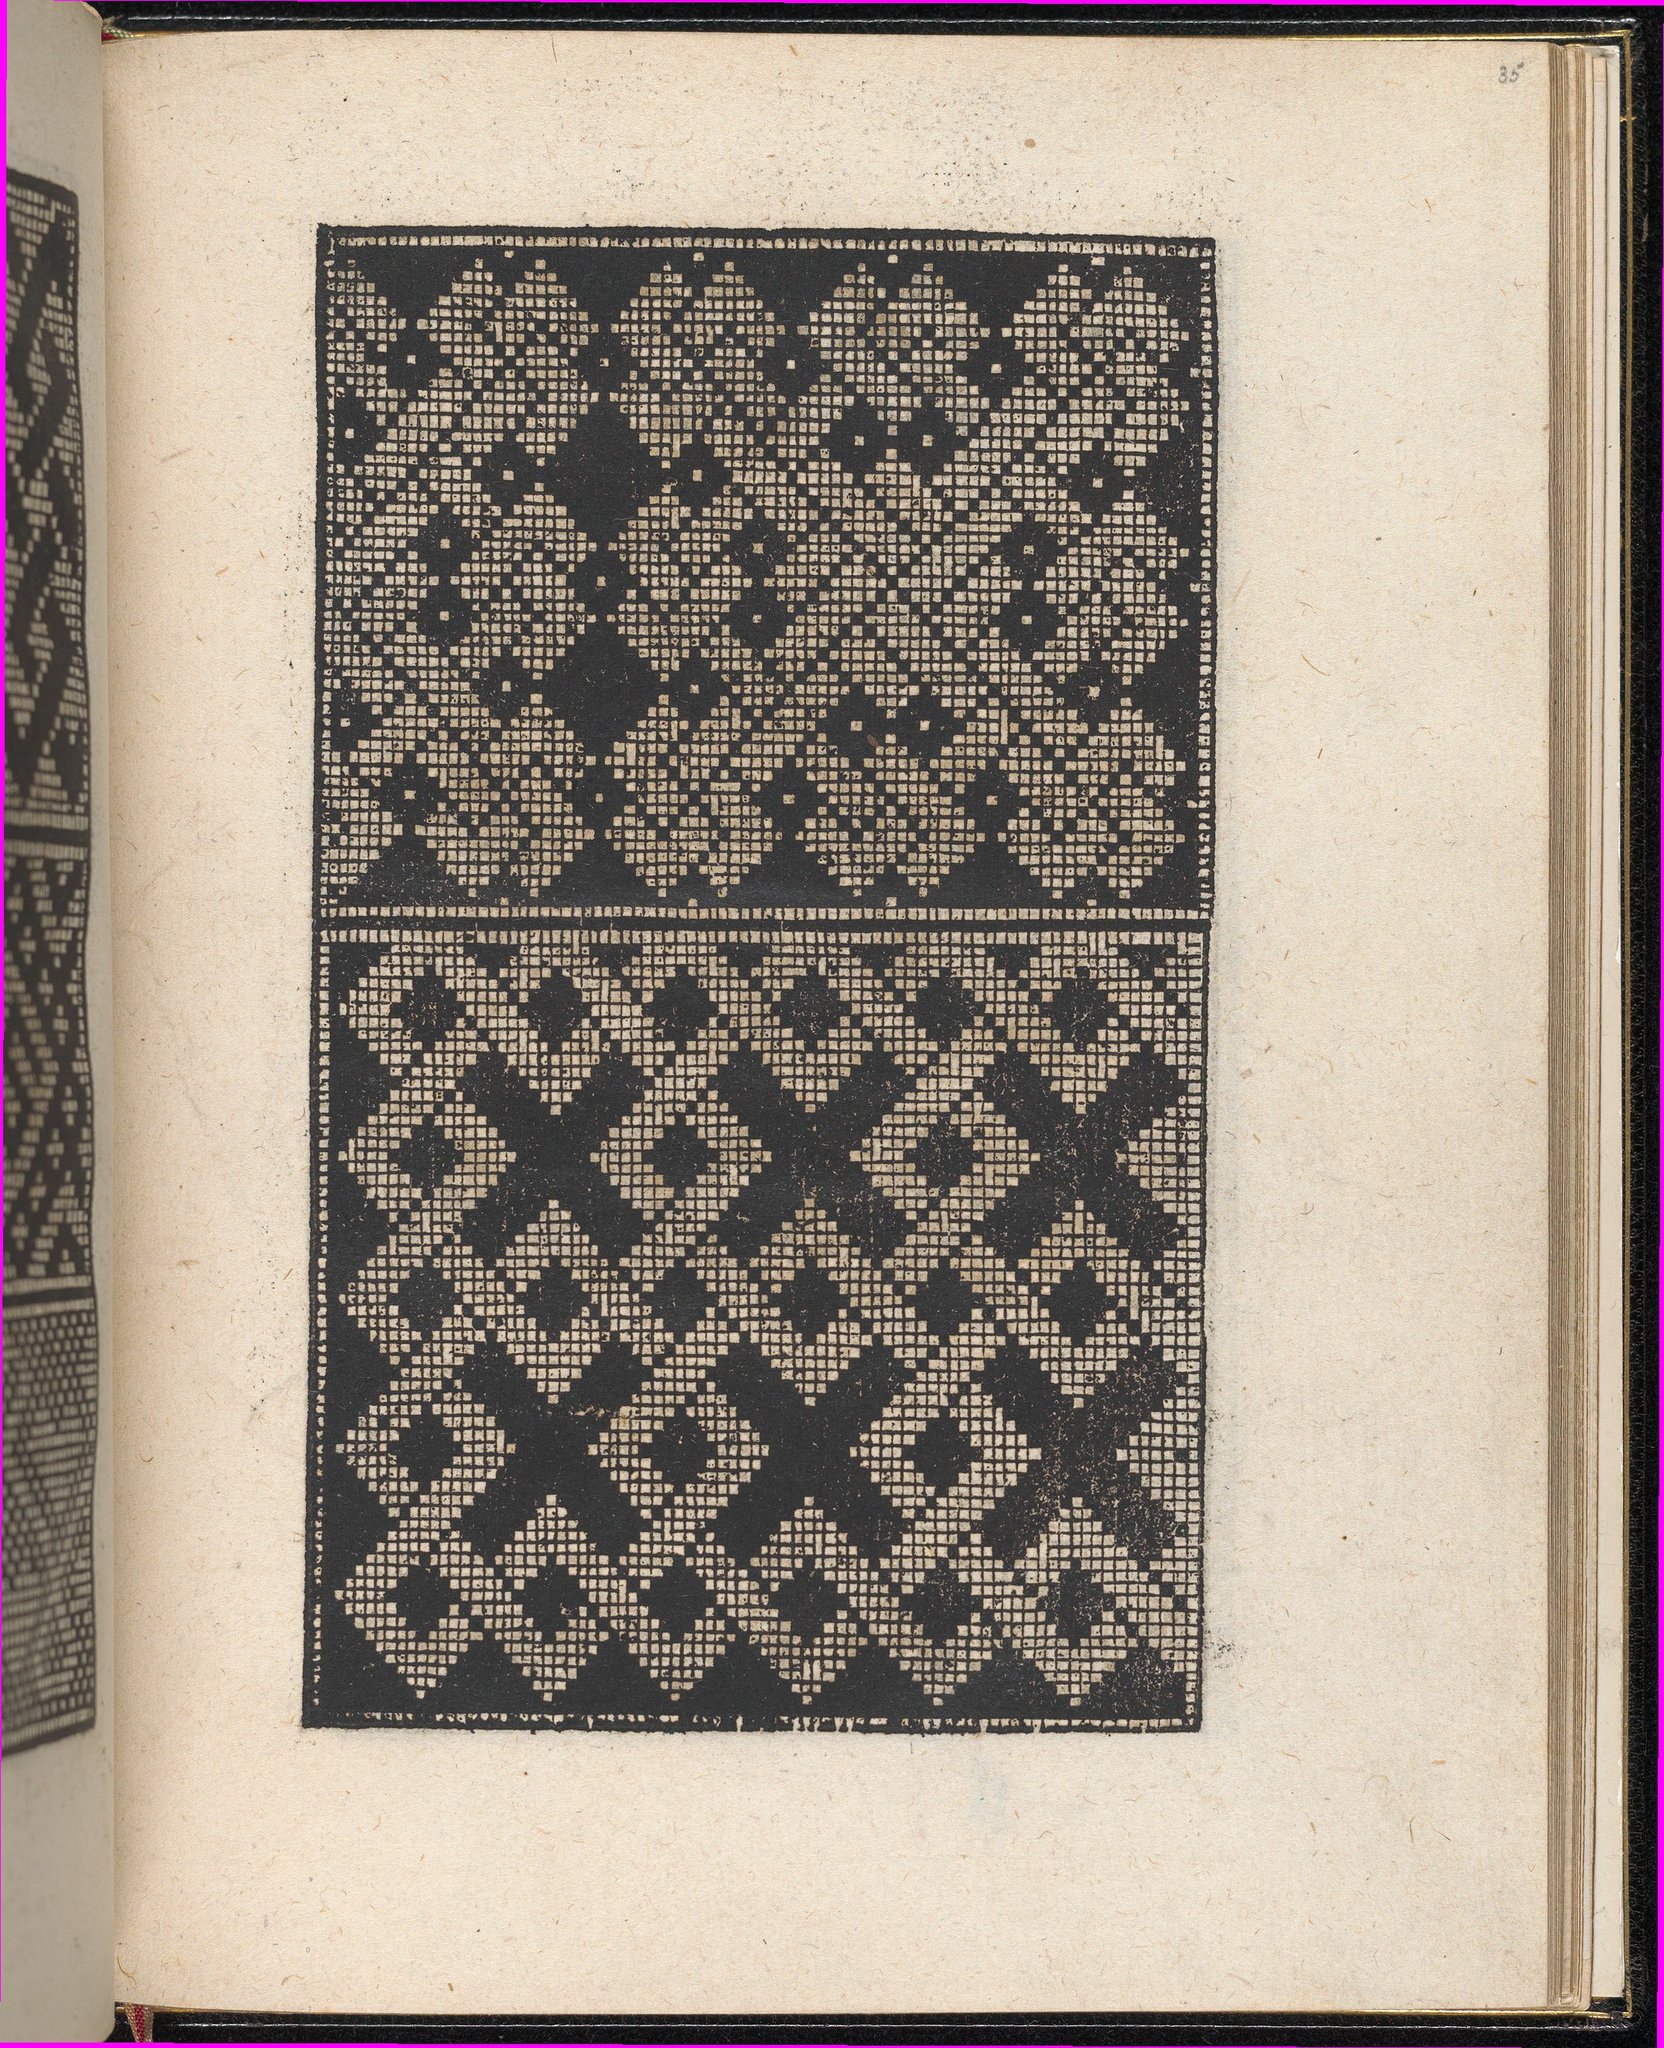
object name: book print ornament architecture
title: Page from Ein new kunstlich Modelbuch...(Page 35r)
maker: peter quentel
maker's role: publisher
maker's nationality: german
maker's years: 1500-1550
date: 1544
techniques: woodcut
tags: ornament